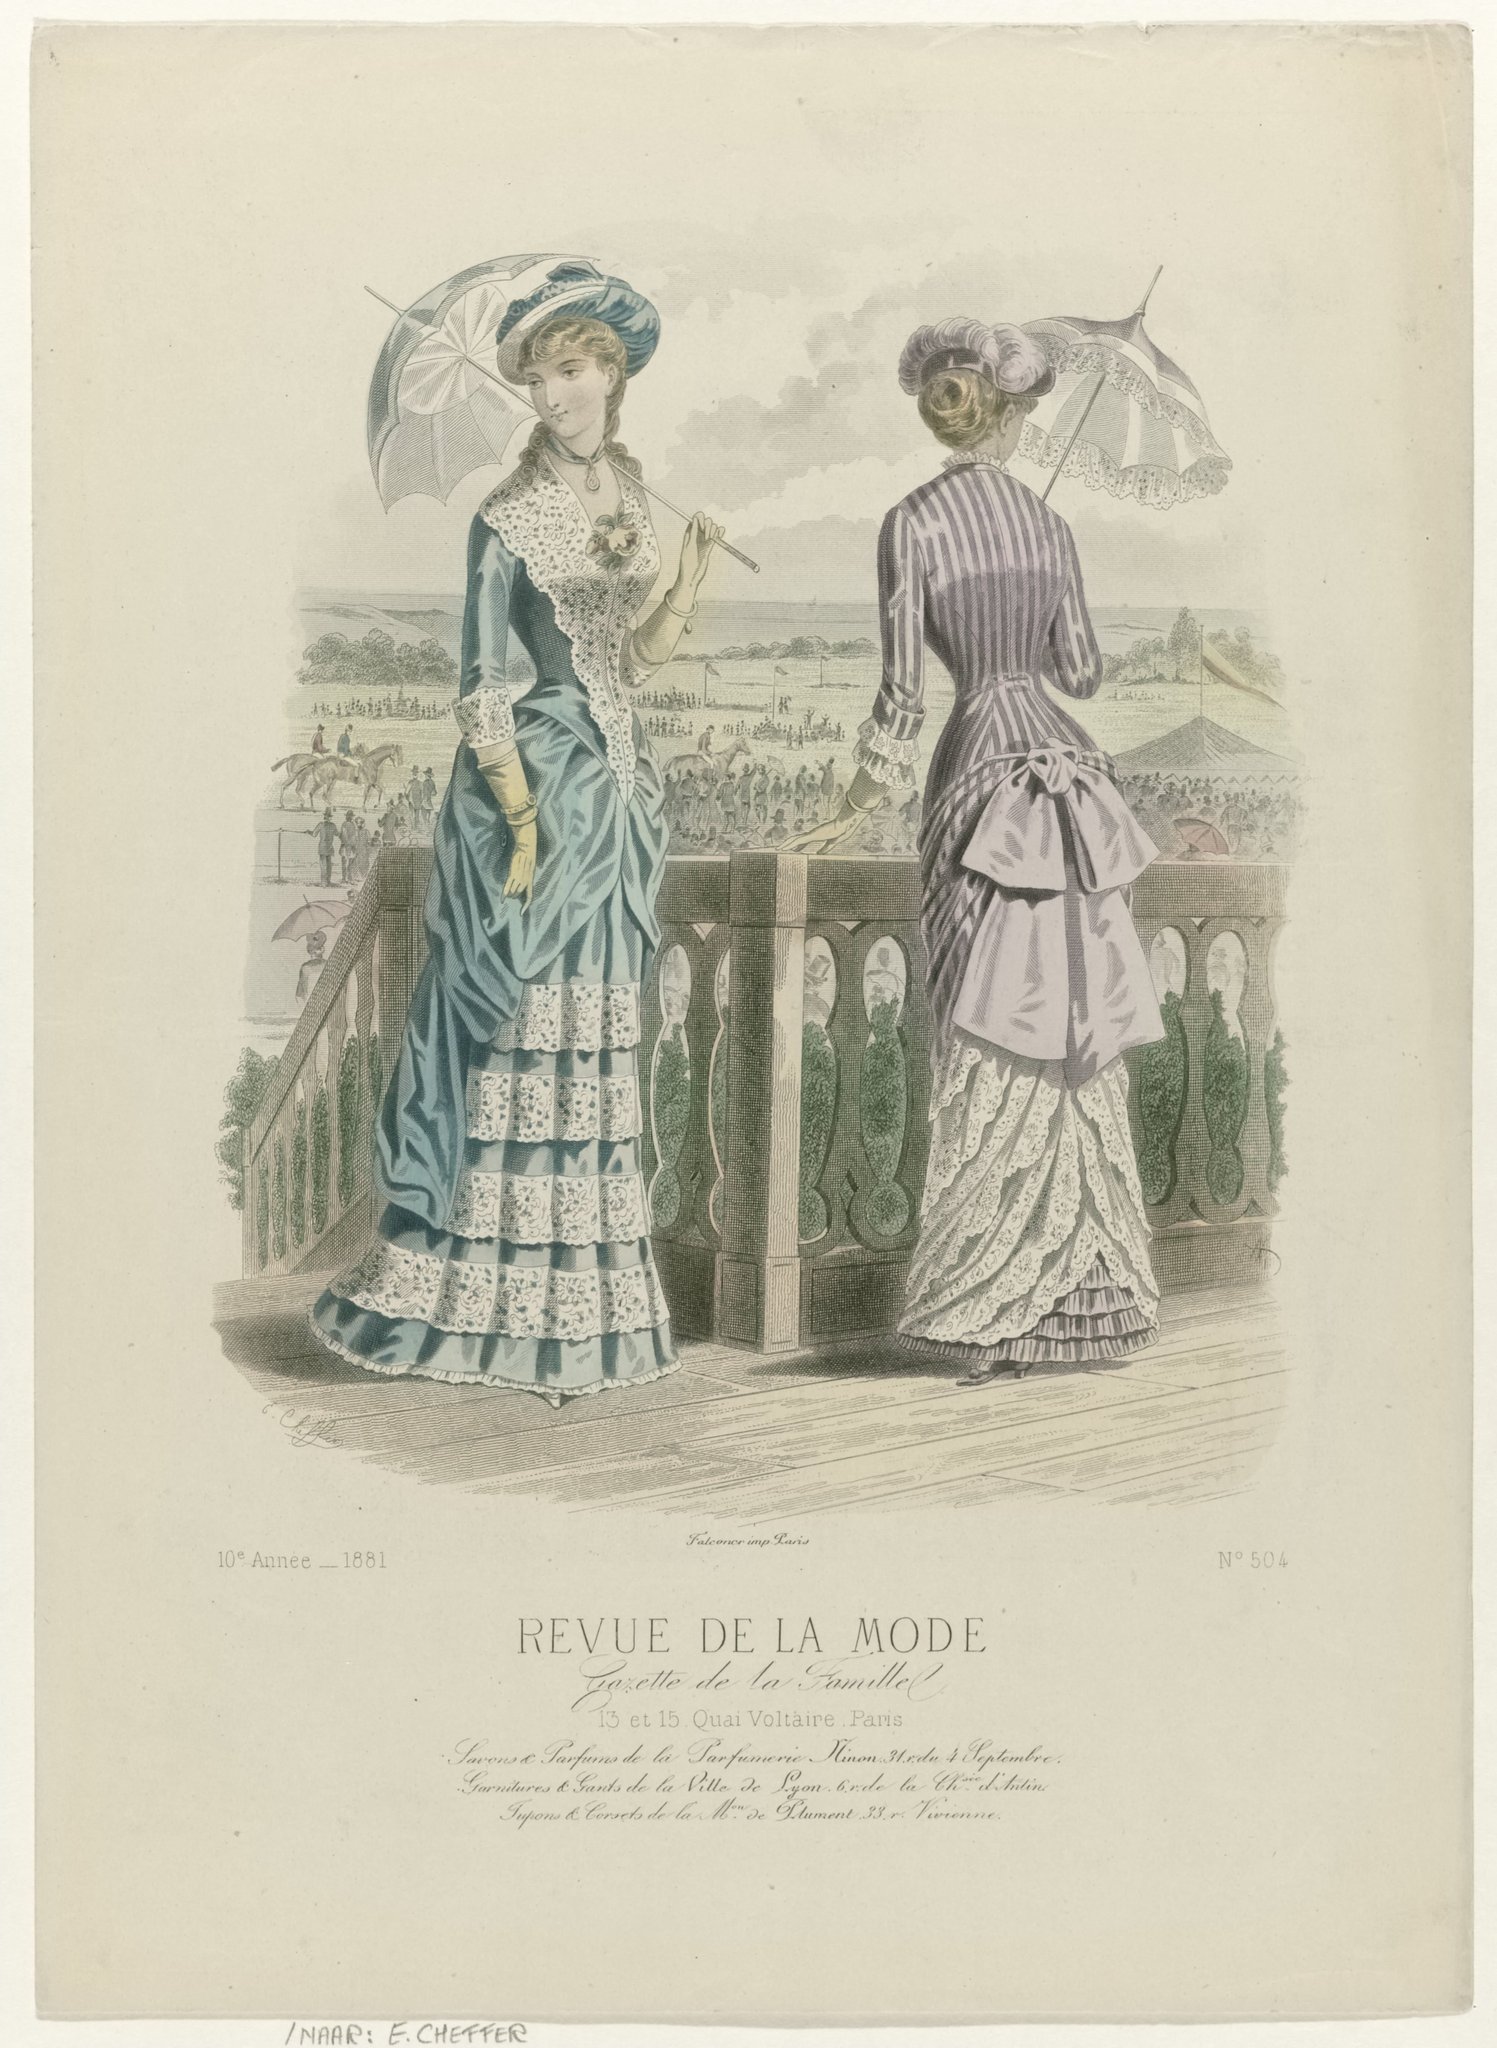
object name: fashion print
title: Revue de la Mode, Gazette de la Famille, dimanche 28 août 1881, 10e année, No. 504: Savons & Parfums de la Parfumerie Ninon (...)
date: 1881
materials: paper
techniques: engraving, hand coloring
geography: paris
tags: corsage (+ women's clothes), pendant, trinket, 'breloque' (+ women's clothes), gloves, mittens (long gloves) (+ women's clothes), lace (+ women's clothes), fashion plates, head-gear: hat (+ women's clothes), skirt (+ women's clothes), dress, gown (+ women's clothes), race-track, bracelet, wristlet (+ women's clothes), parasol, sunshade (+ women's clothes)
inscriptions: address: ‘13 et 15, Quai Voltaire, Paris’, title: ‘REVUE DE LA MODE / Gazette de la Famille’, caption: ‘Savons & parfums de la Parfumerie Ninon, 31, r. du 4 Septembre. Garnitures & Gants de la Ville de Lyon, 6, r. de la Ch.sée d'Antin. Jupons & Corsets de la M.on de Plument, 33, r. Vivienne.’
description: Twee vrouwen met parasols, gekleed in 'toilettes' voor de paardenraces. Links: japon van lichtgroene 'satin merveilleux' (satijn) en ecrukleurig linnenkant (guipure). Rechts: 'toilette' van paarse 'pékin' met strepen van moiré, versierd met wit kant. Onder de voorstelling enkele regels reclametekst voor verschillende producten. Prent uit het modetijdschrift Revue de la Mode (1872-1913). Uitgebreide beschrijving van de kleding op pagina 292 "PLANCHE COLORIÉE".